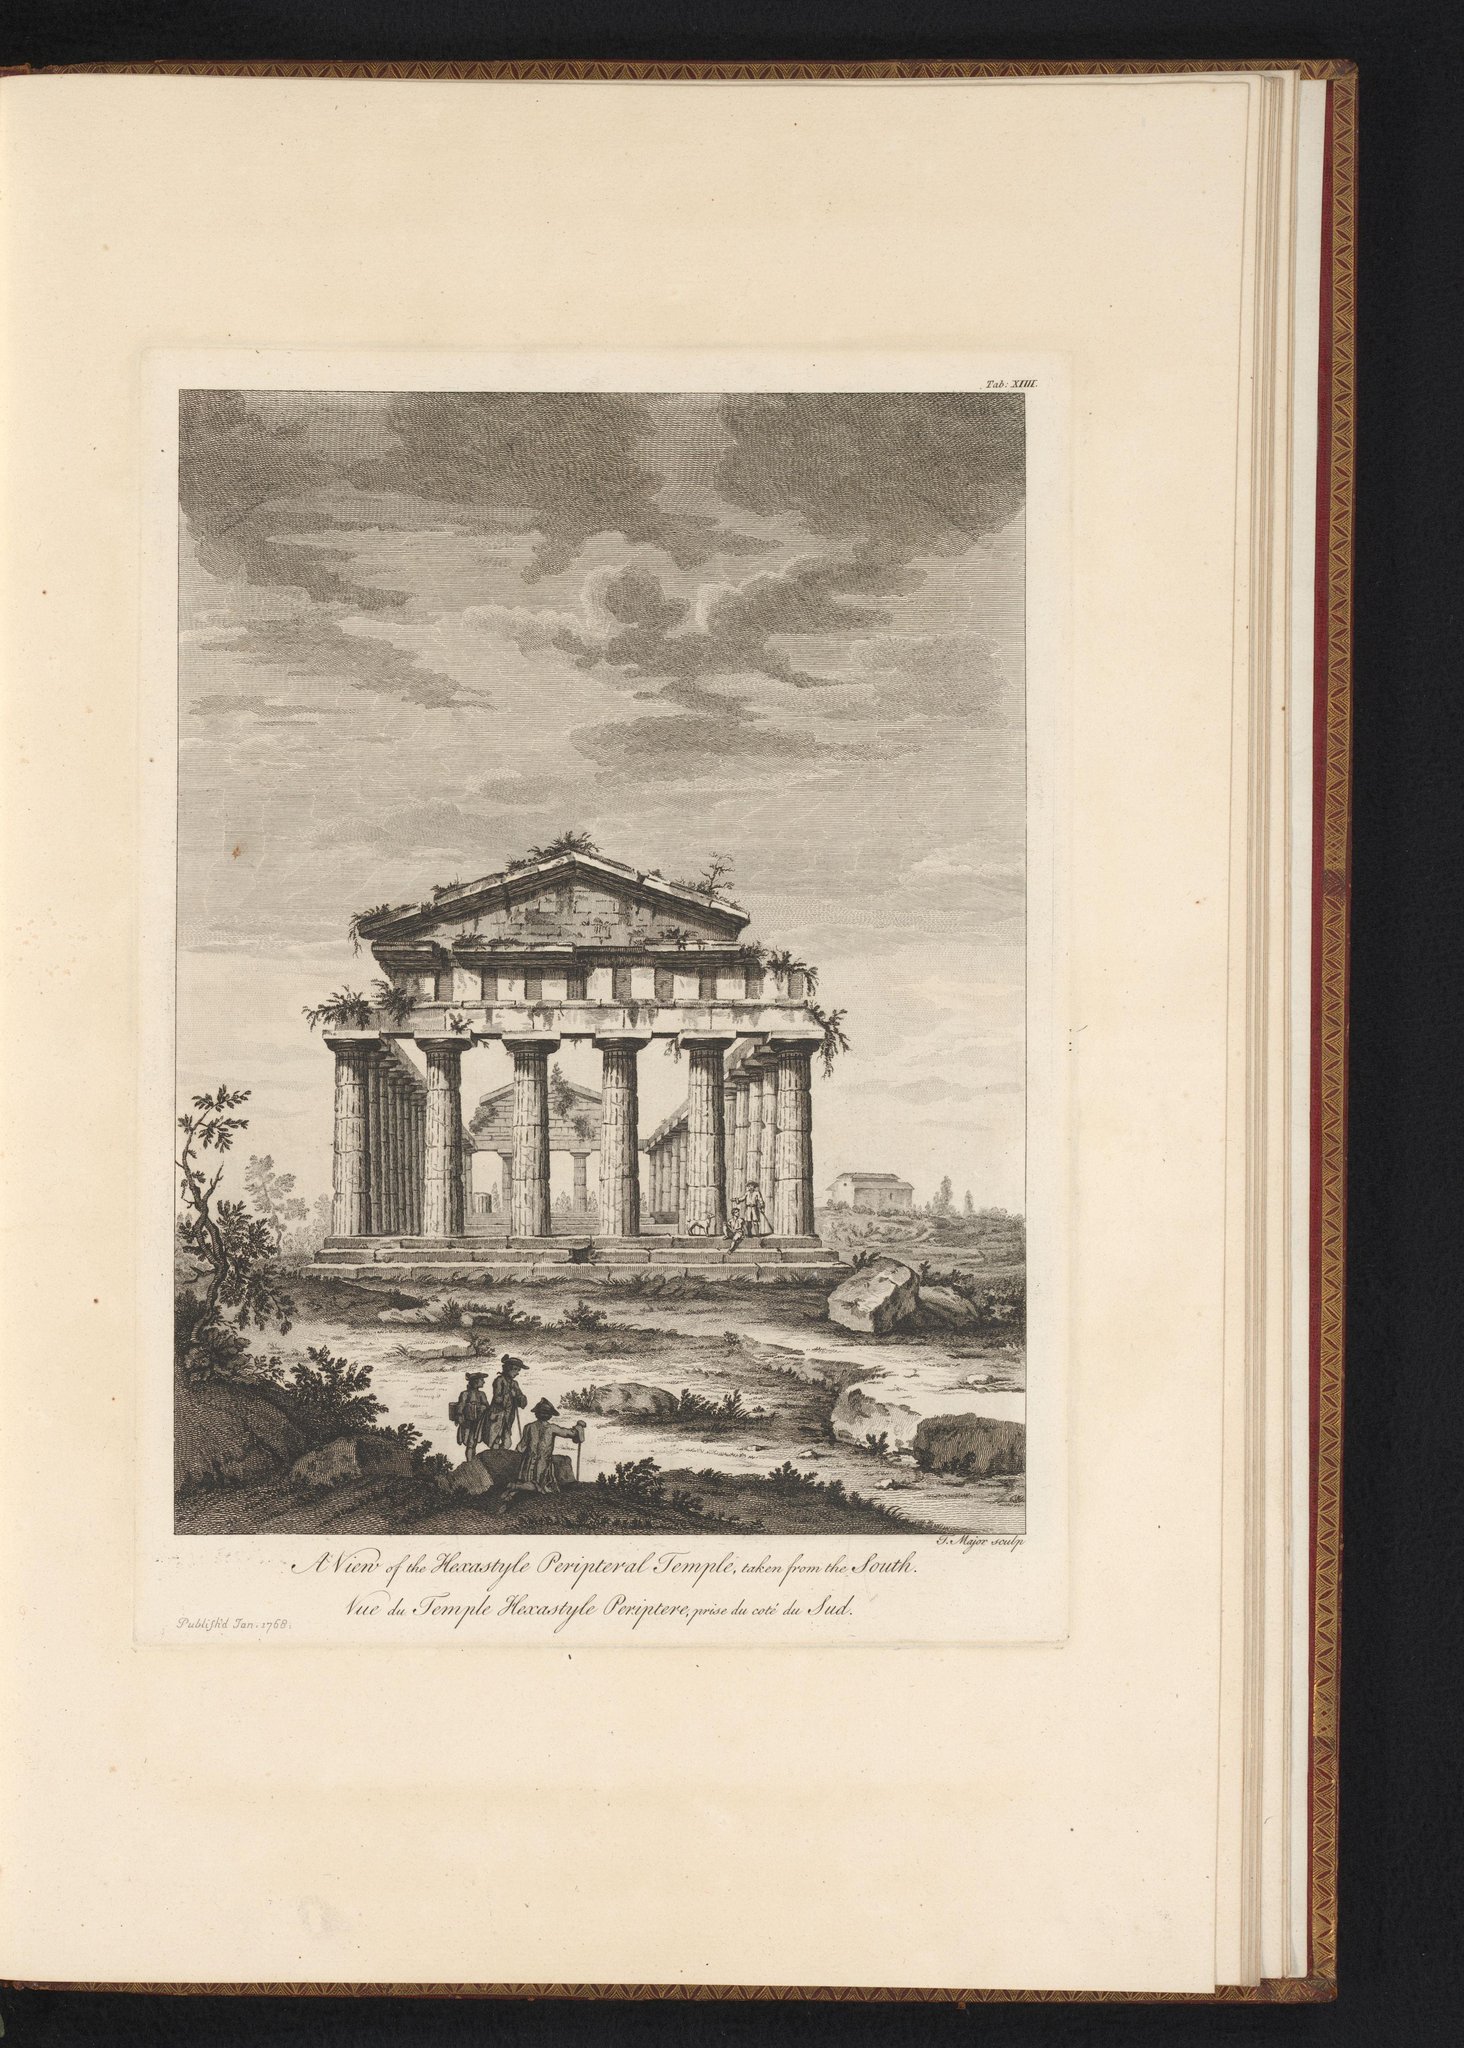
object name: print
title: A View of the Hexastyle Peripteral Temple, taken from the South / Vue du Temple Hexastyle Periptere, prise du coté du Sud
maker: thomas major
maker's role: print maker, publisher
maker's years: 1714-1799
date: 1768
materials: paper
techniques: engraving, etching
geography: london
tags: landscape with ruins (+ city(-scape) with figures, staffage), temple, shrine ~ greek religion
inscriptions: date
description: Deze prent is onderdeel van de reeks van 25 genummerde illustraties in deze uitgave.